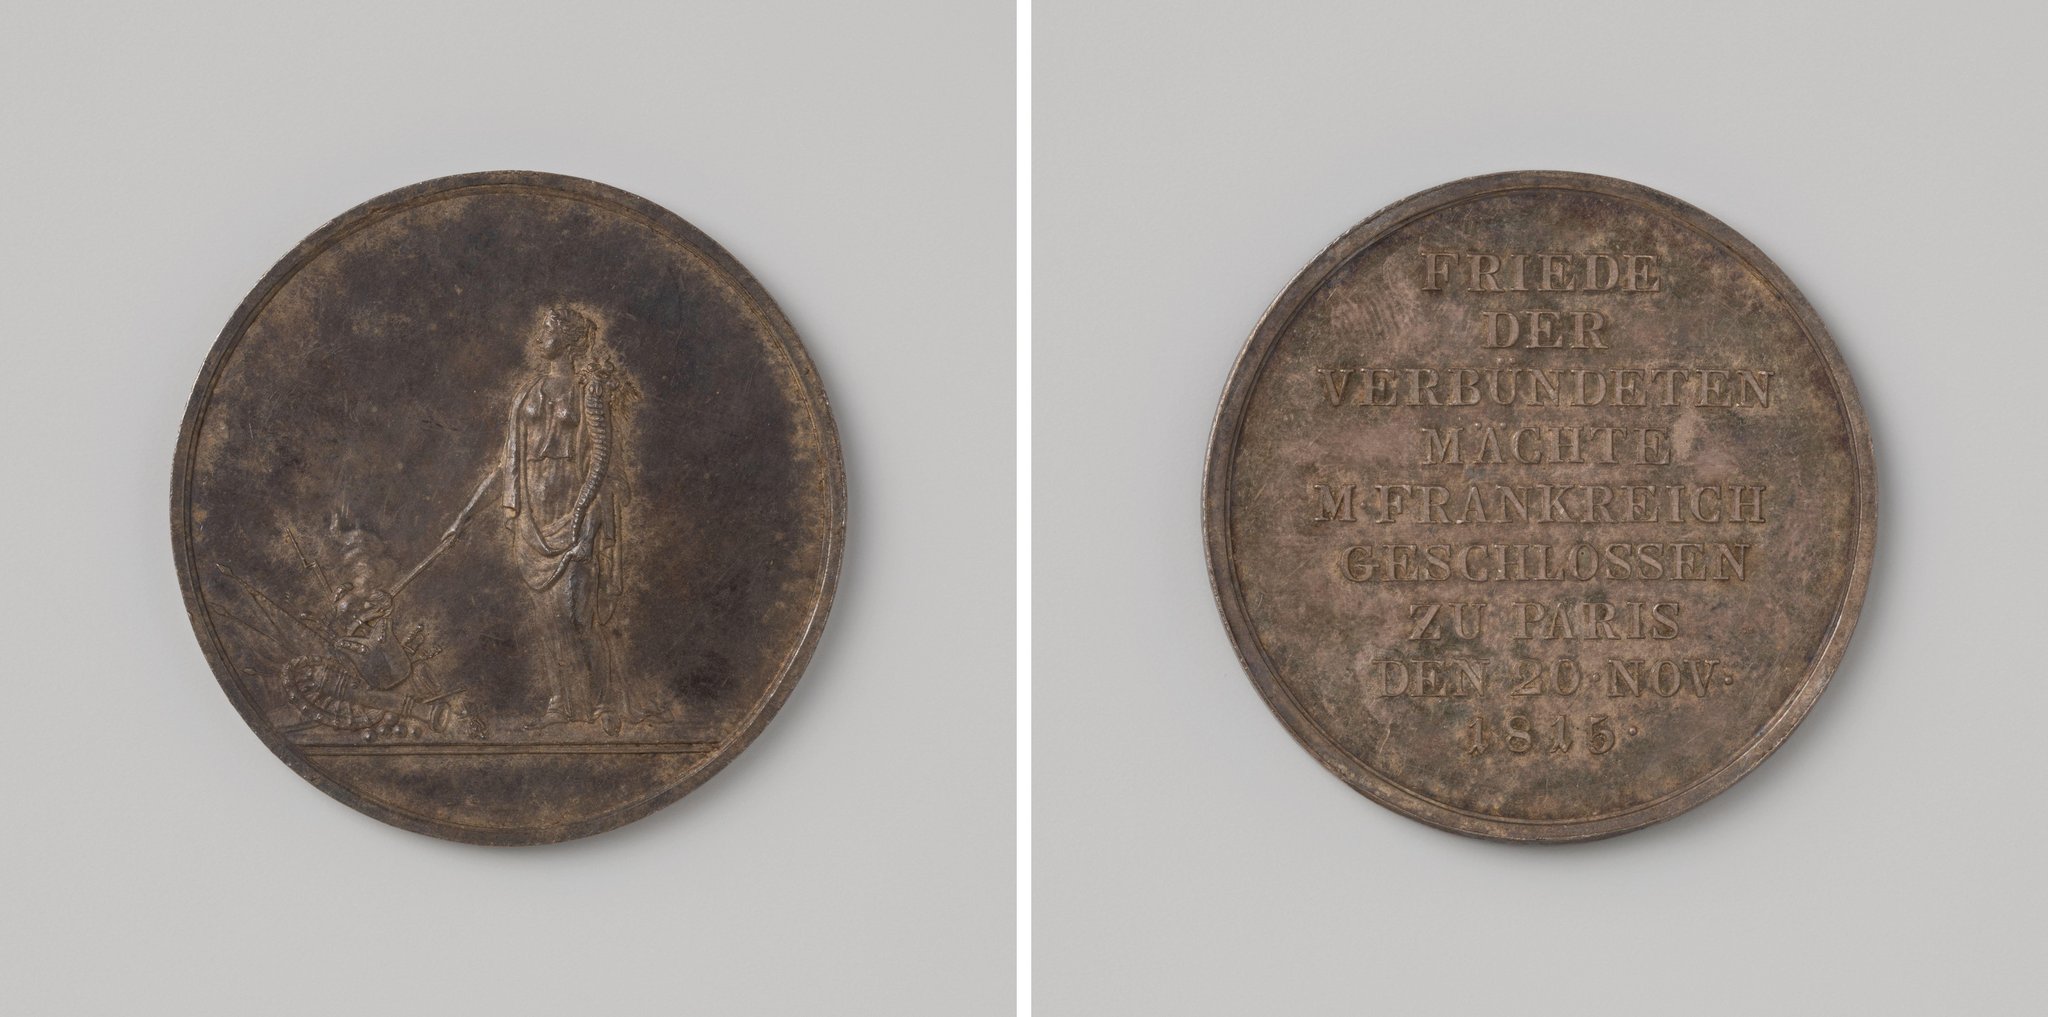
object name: strooipenning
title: Tweede vrede van Parijs tussen Frankrijk en de geallieerden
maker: Anonymous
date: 1815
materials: silver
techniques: striking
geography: germany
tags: paris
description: Zilveren penning. Voorzijde: Vrede met gevulde hoorn van overvloed in hand steekt met toorts stapel krijgstuig in brand. Keerzijde: opschrift